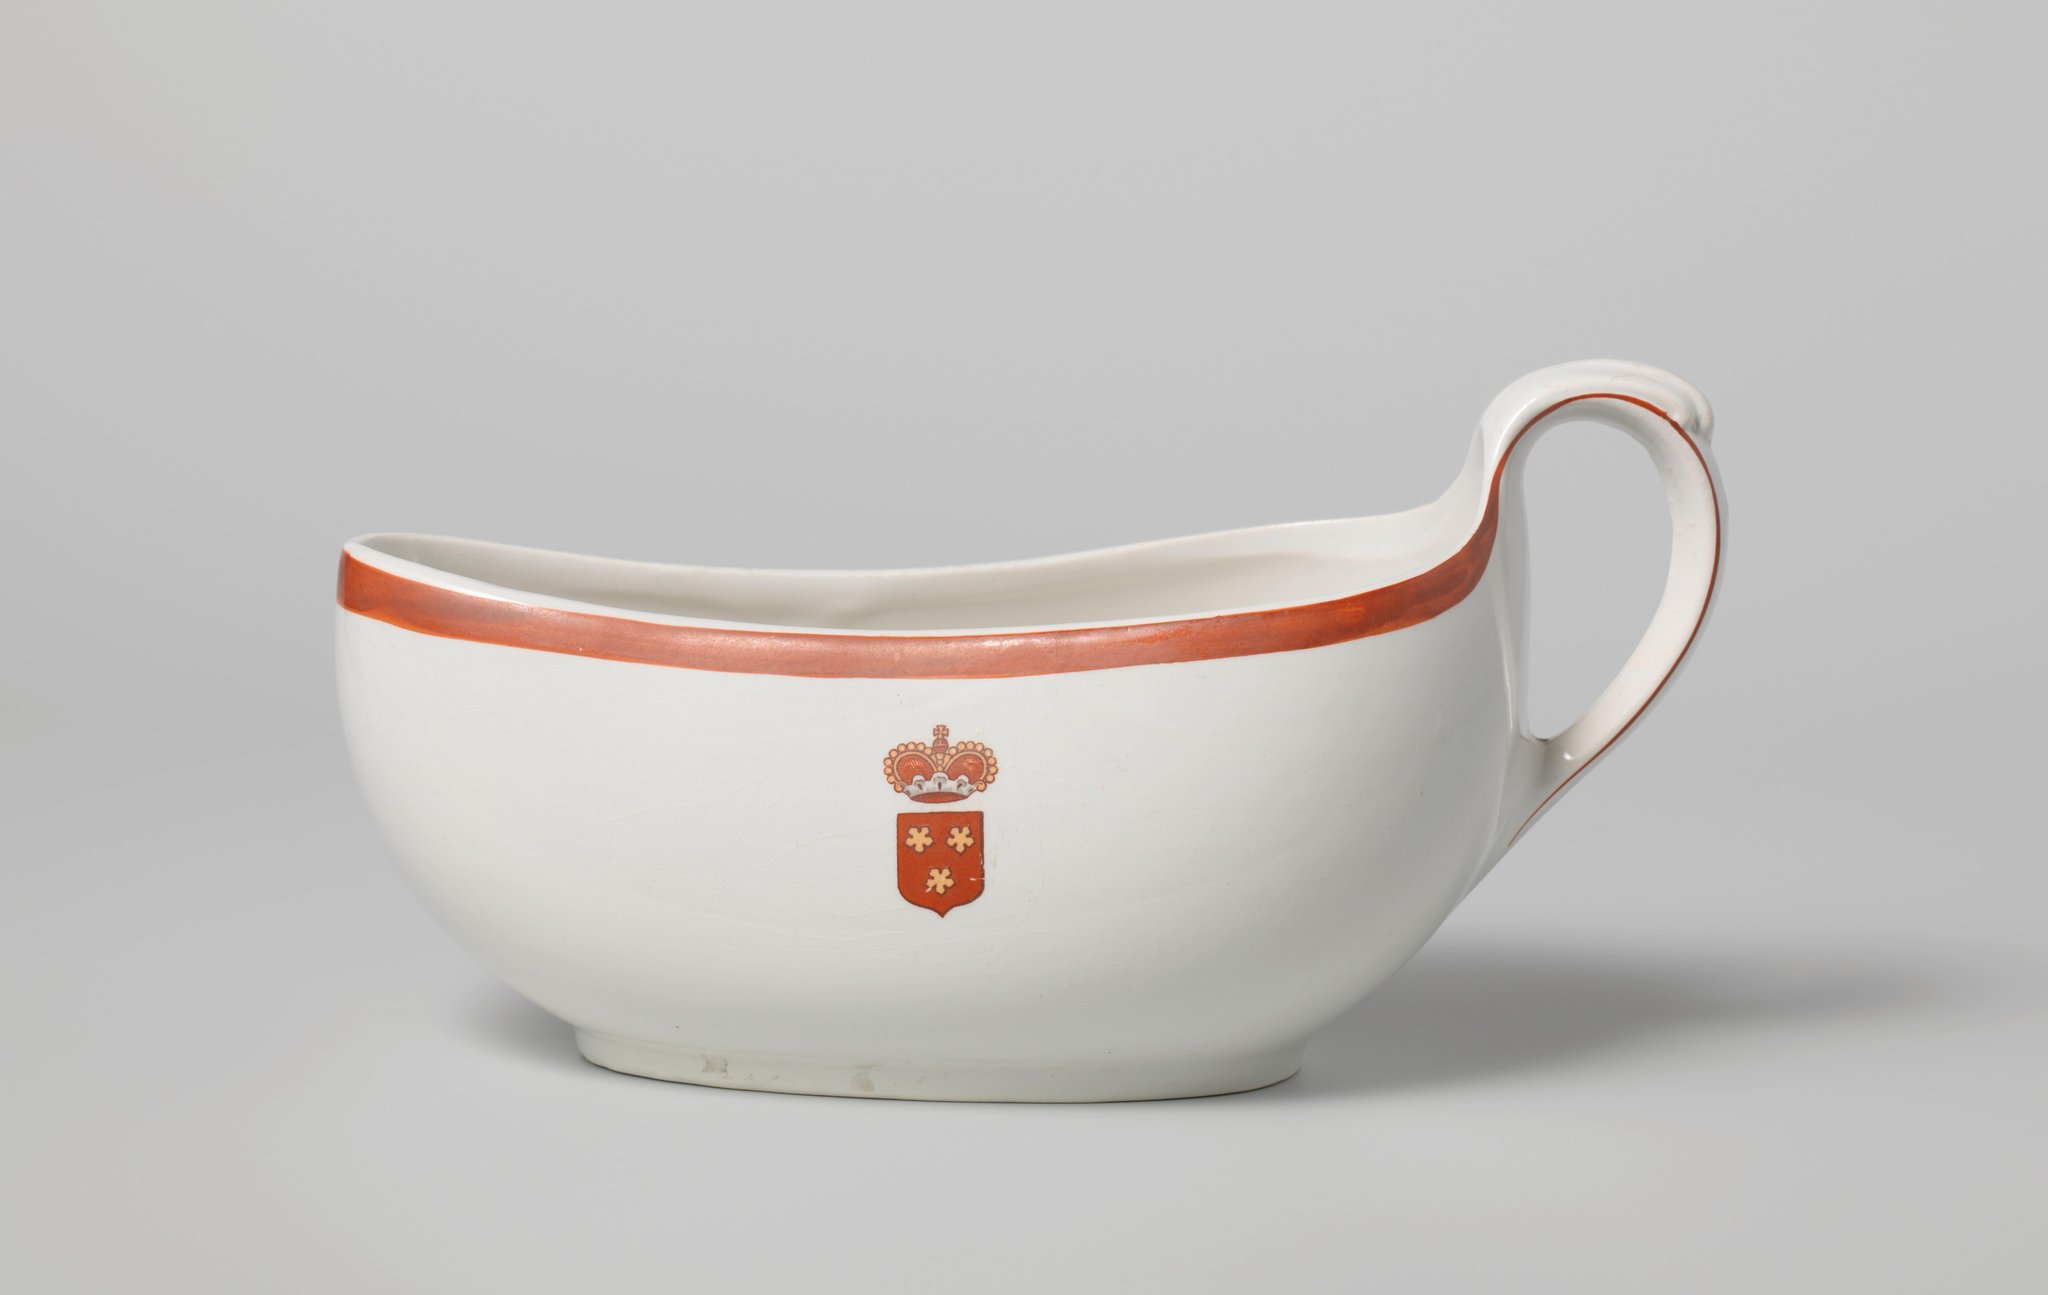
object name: bourdalou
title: Bourdalou, deel van een toiletgarnituur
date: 1874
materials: earthenware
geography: wallerfangen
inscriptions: mark: ‘beeldmerk van Villeroy & Boch van 1874’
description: Bourdalou, deel van een toiletgarnituur van aardewerk. Versierd met rode biezen en het wapen van de Hertog van Arenberg met kroon in rood en geel.